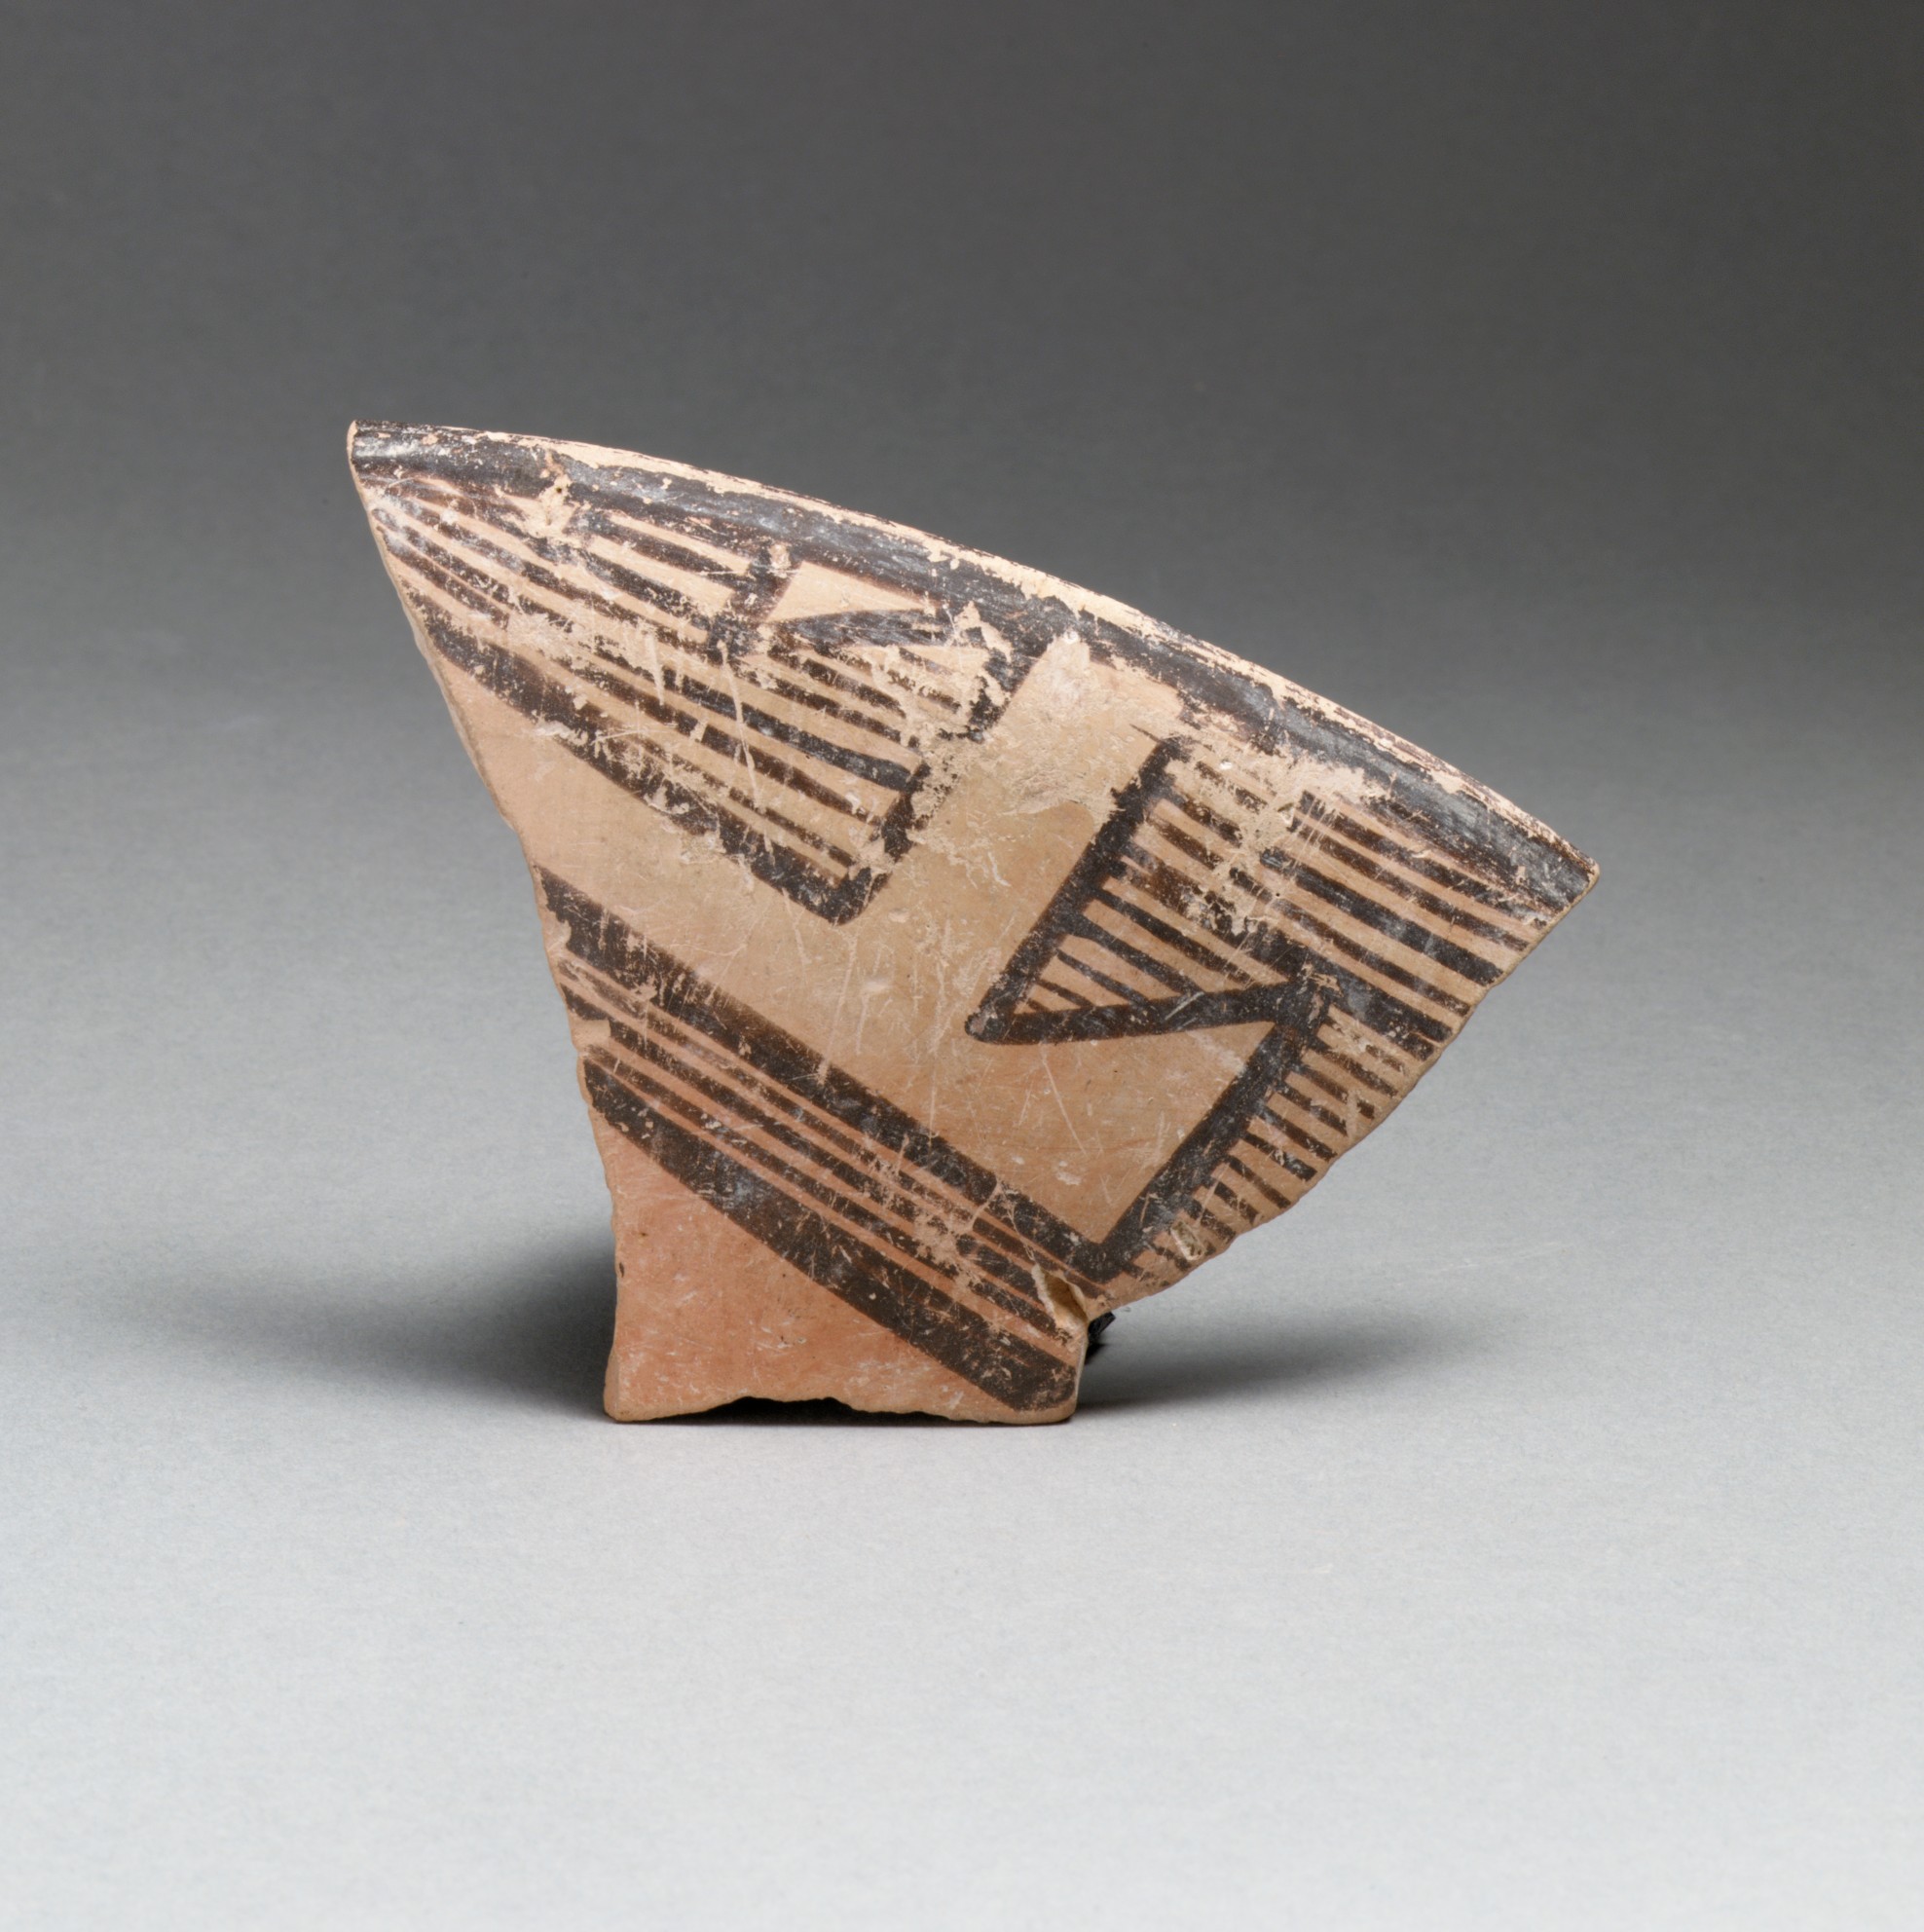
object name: vase fragment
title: Terracotta rim of a bowl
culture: dimini culture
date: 3800-3300 BCE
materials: terracotta